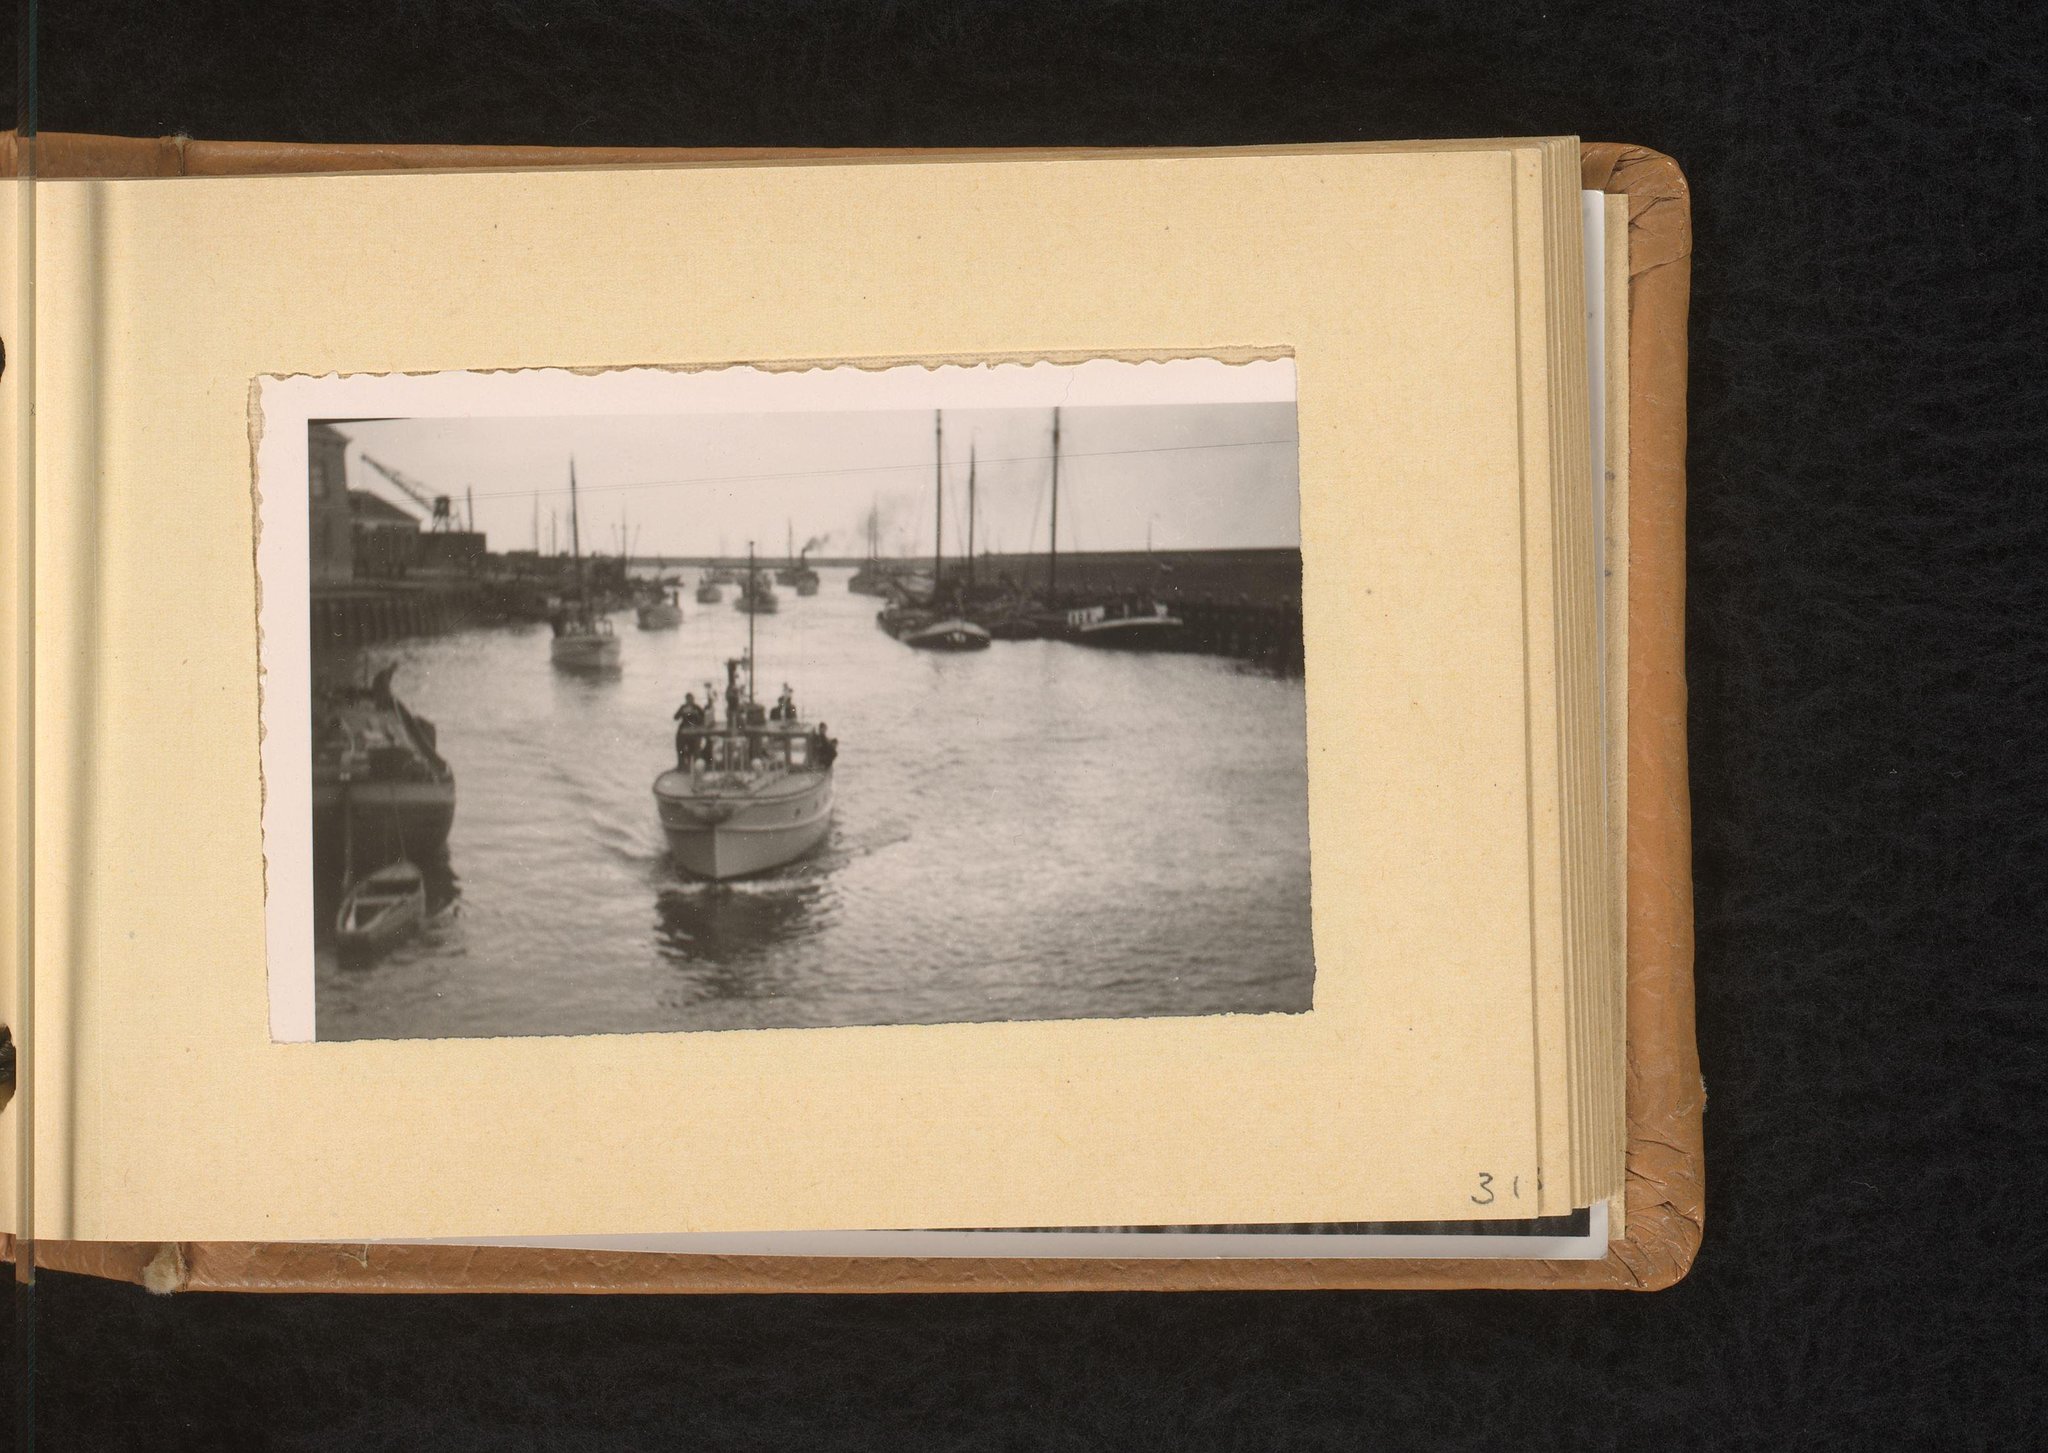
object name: photograph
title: Schepen van de Kriegsmarine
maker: Anonymous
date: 1940-1943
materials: paper, photographic support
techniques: gelatin silver print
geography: netherlands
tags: harbour, navy (+ motor ships), occupation ~ war, netherlands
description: Albumblad met een foto van een aantal kleine schepen van de Kriegsmarine die een haven uitvaren. Onderdeel van een klein album van de Kriegsmarine in Nederland.